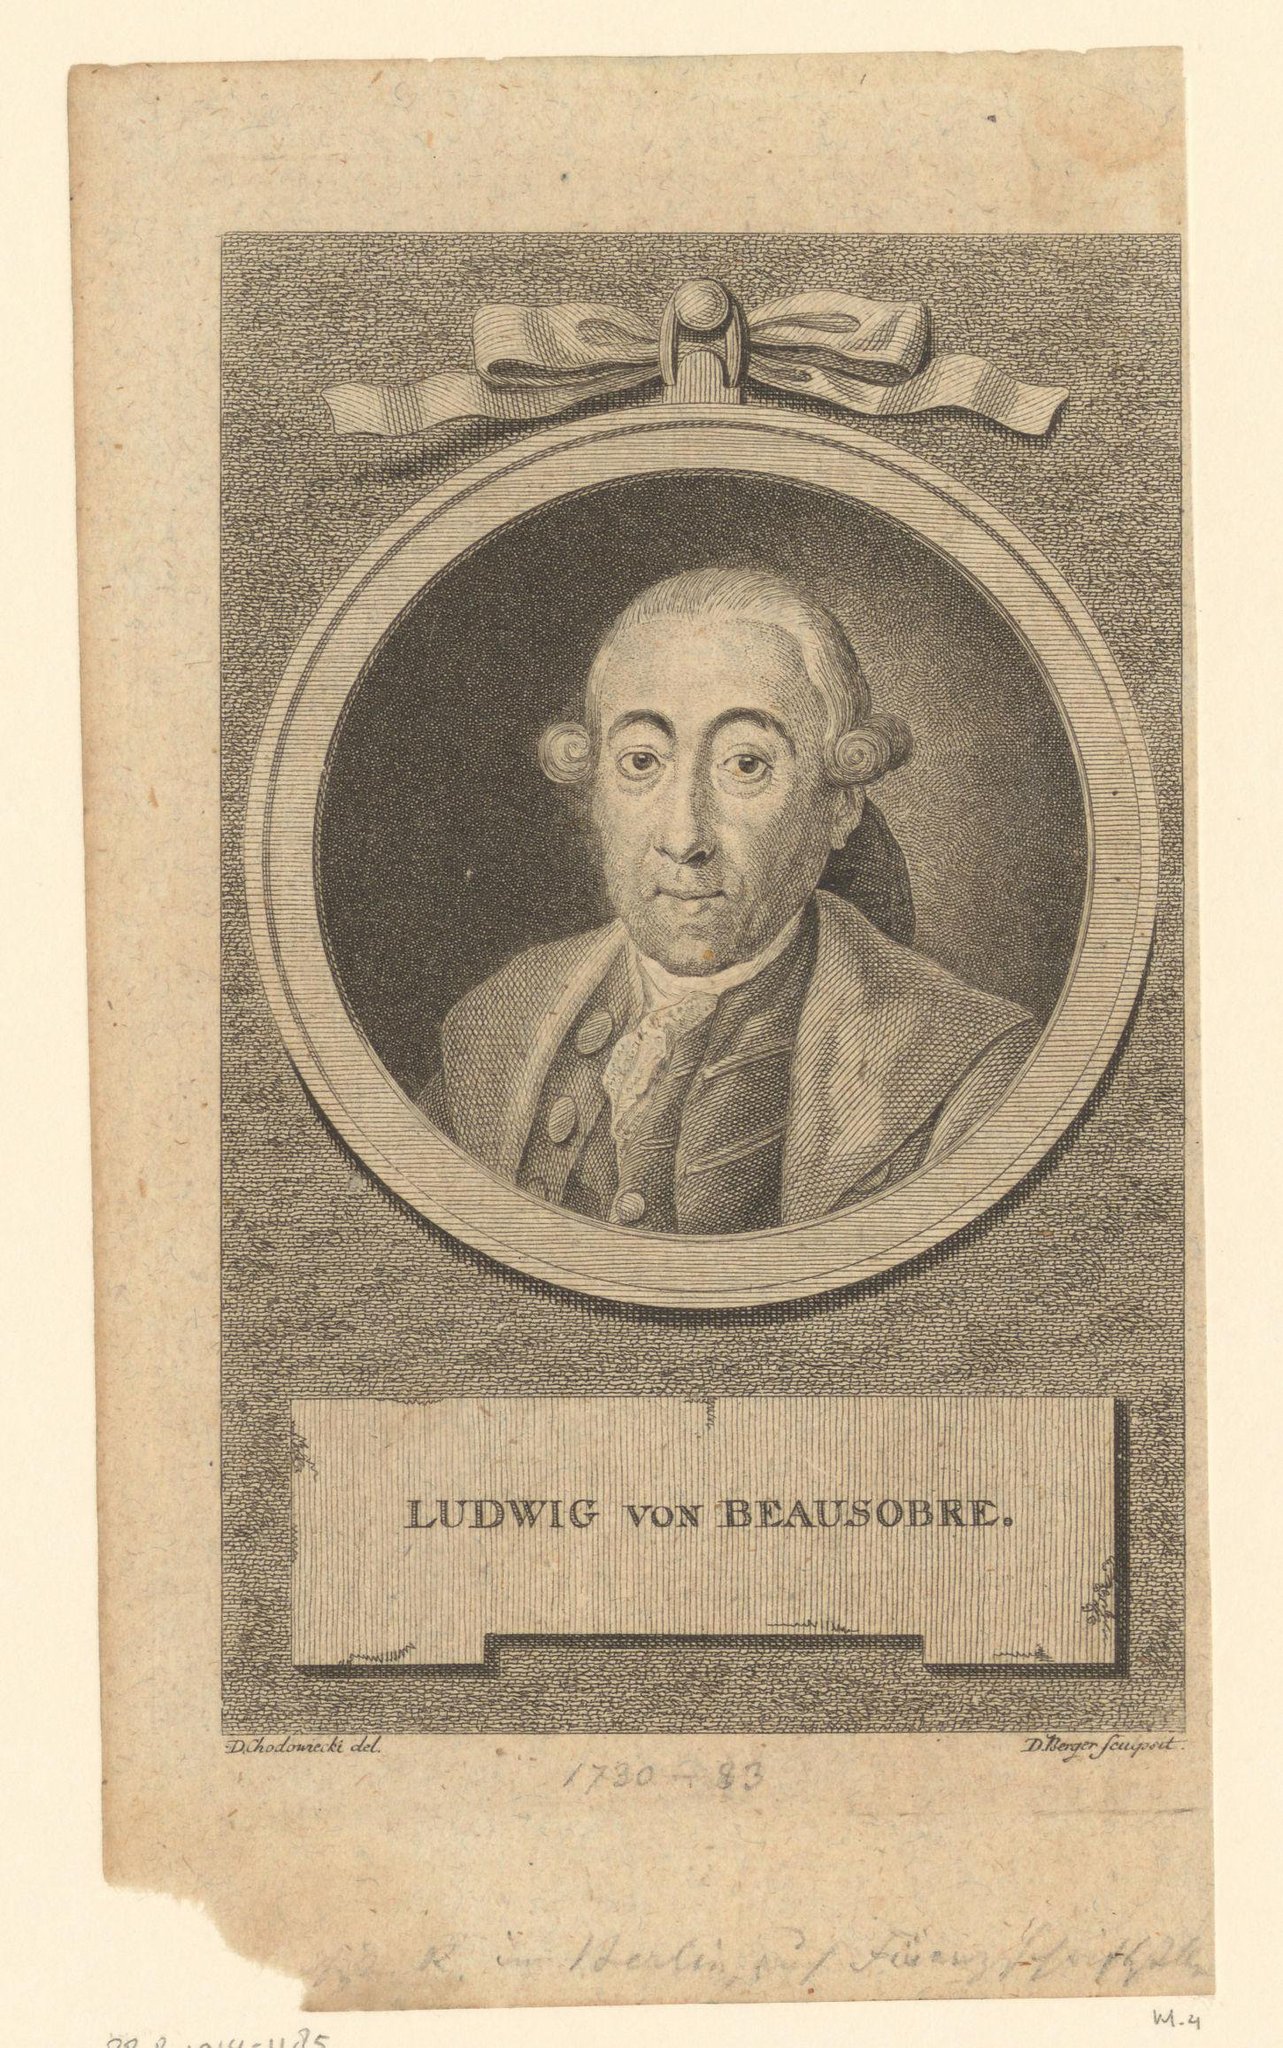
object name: print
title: Portret van Ludwig von Beausobre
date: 1779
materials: paper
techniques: engraving, etching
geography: berlin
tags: historical persons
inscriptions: collector's mark: Lugt 2228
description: Prent ook gebruikt in: Krünitz, Johann Georg. Oeconomische Encyclopädie. dl. 17. Berlijn: Joachim Pauli, 1779.